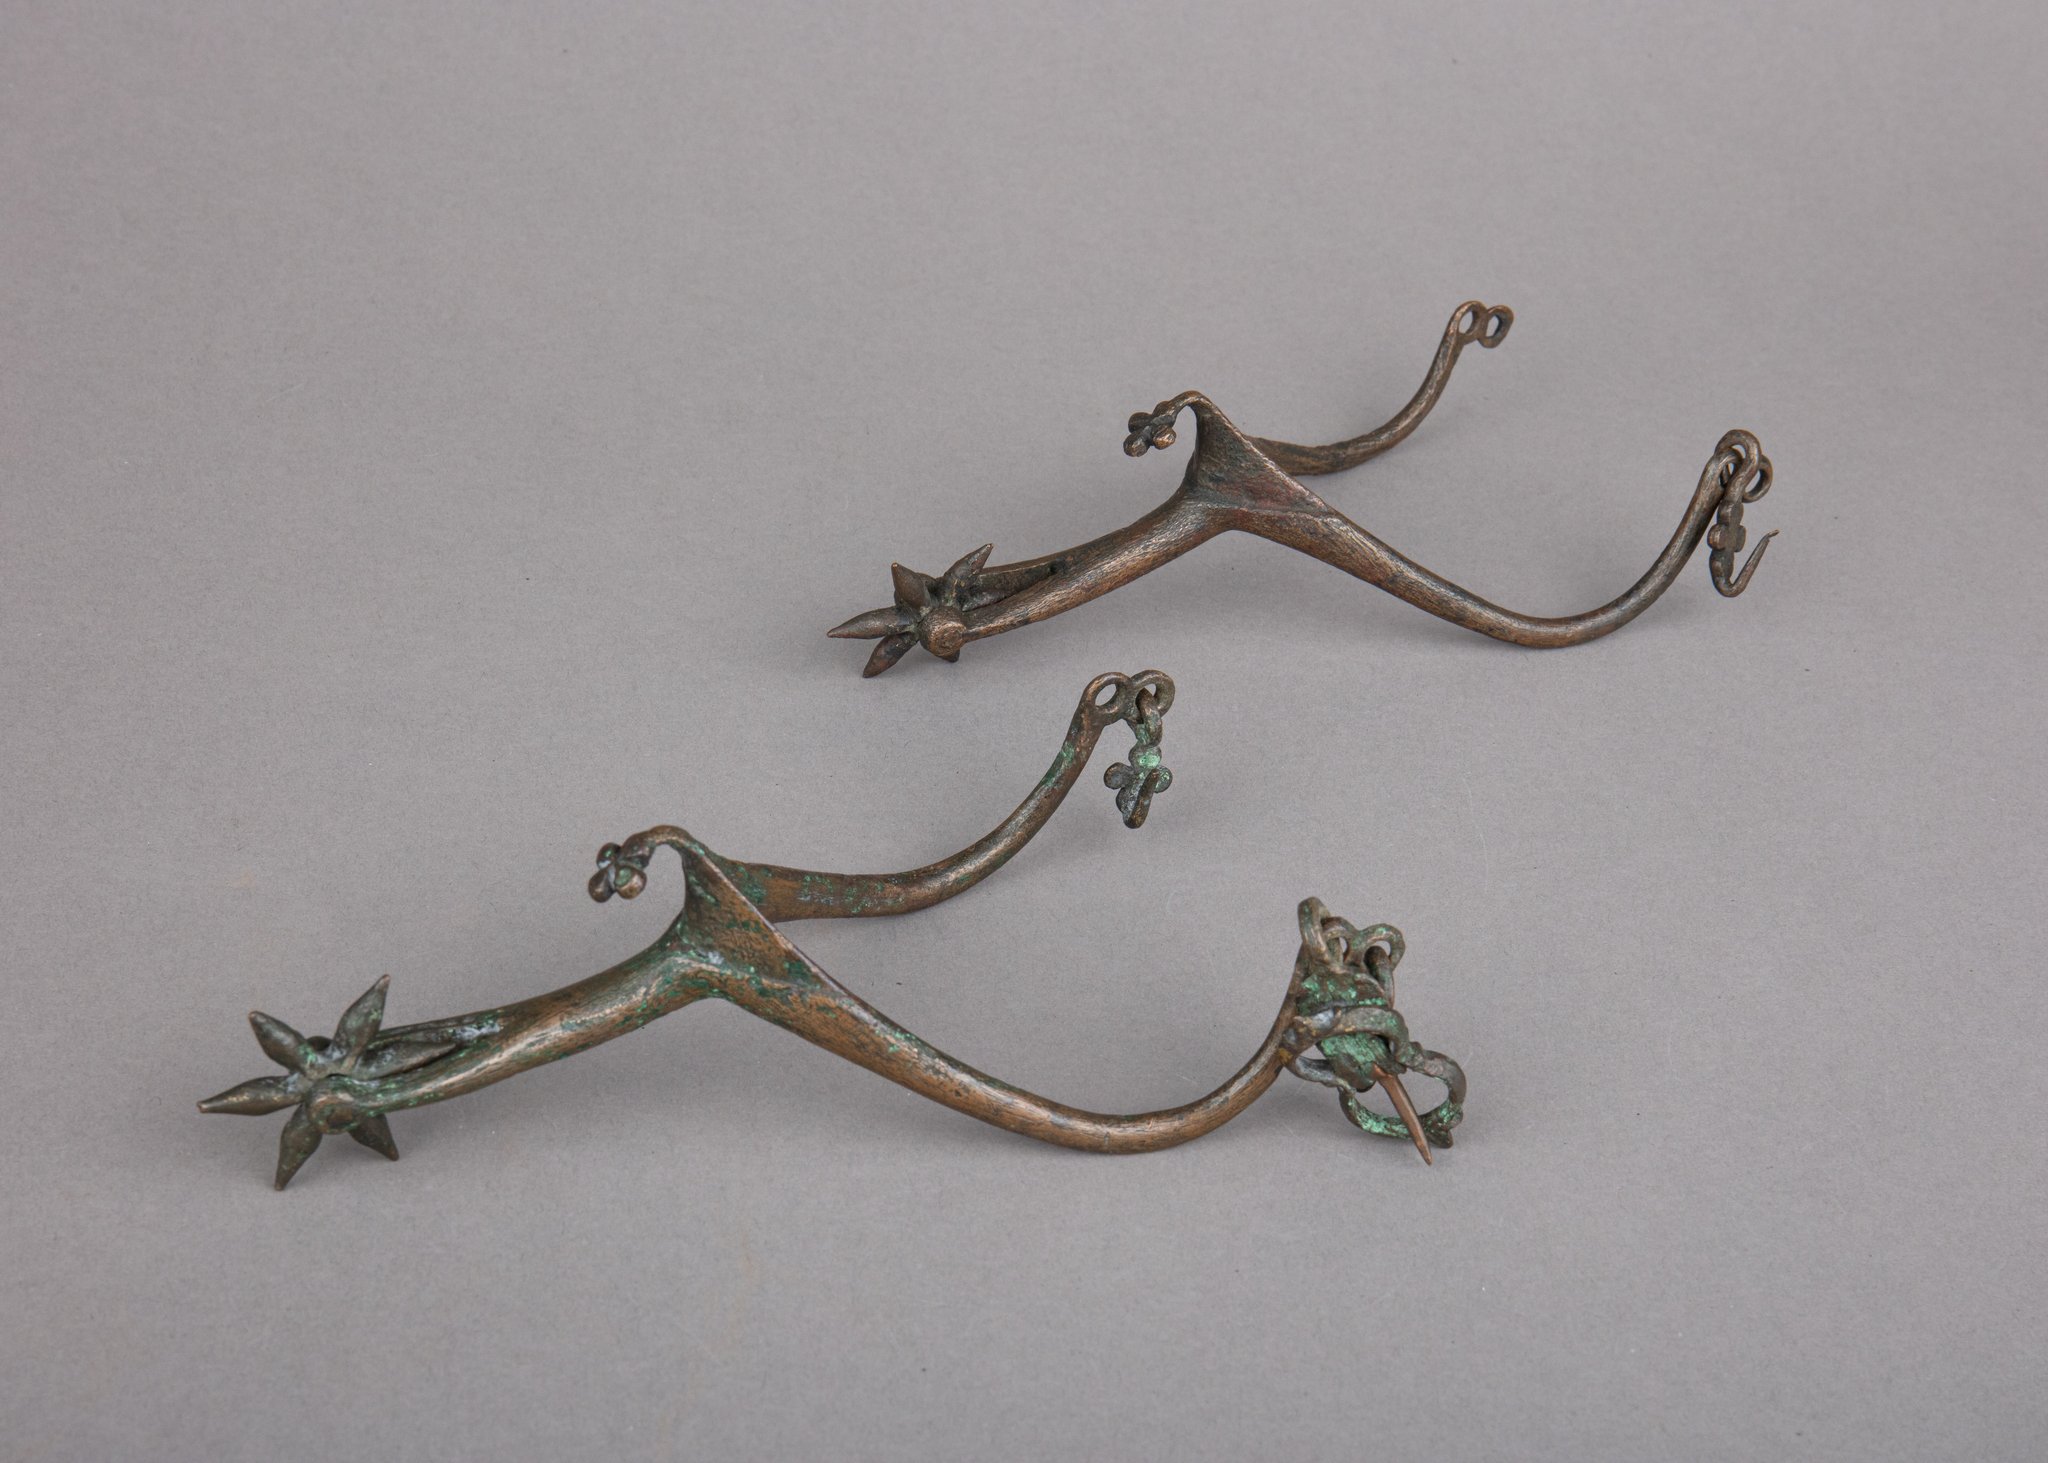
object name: spur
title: Pair of Rowel Spurs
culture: european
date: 1400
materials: copper alloy, gold